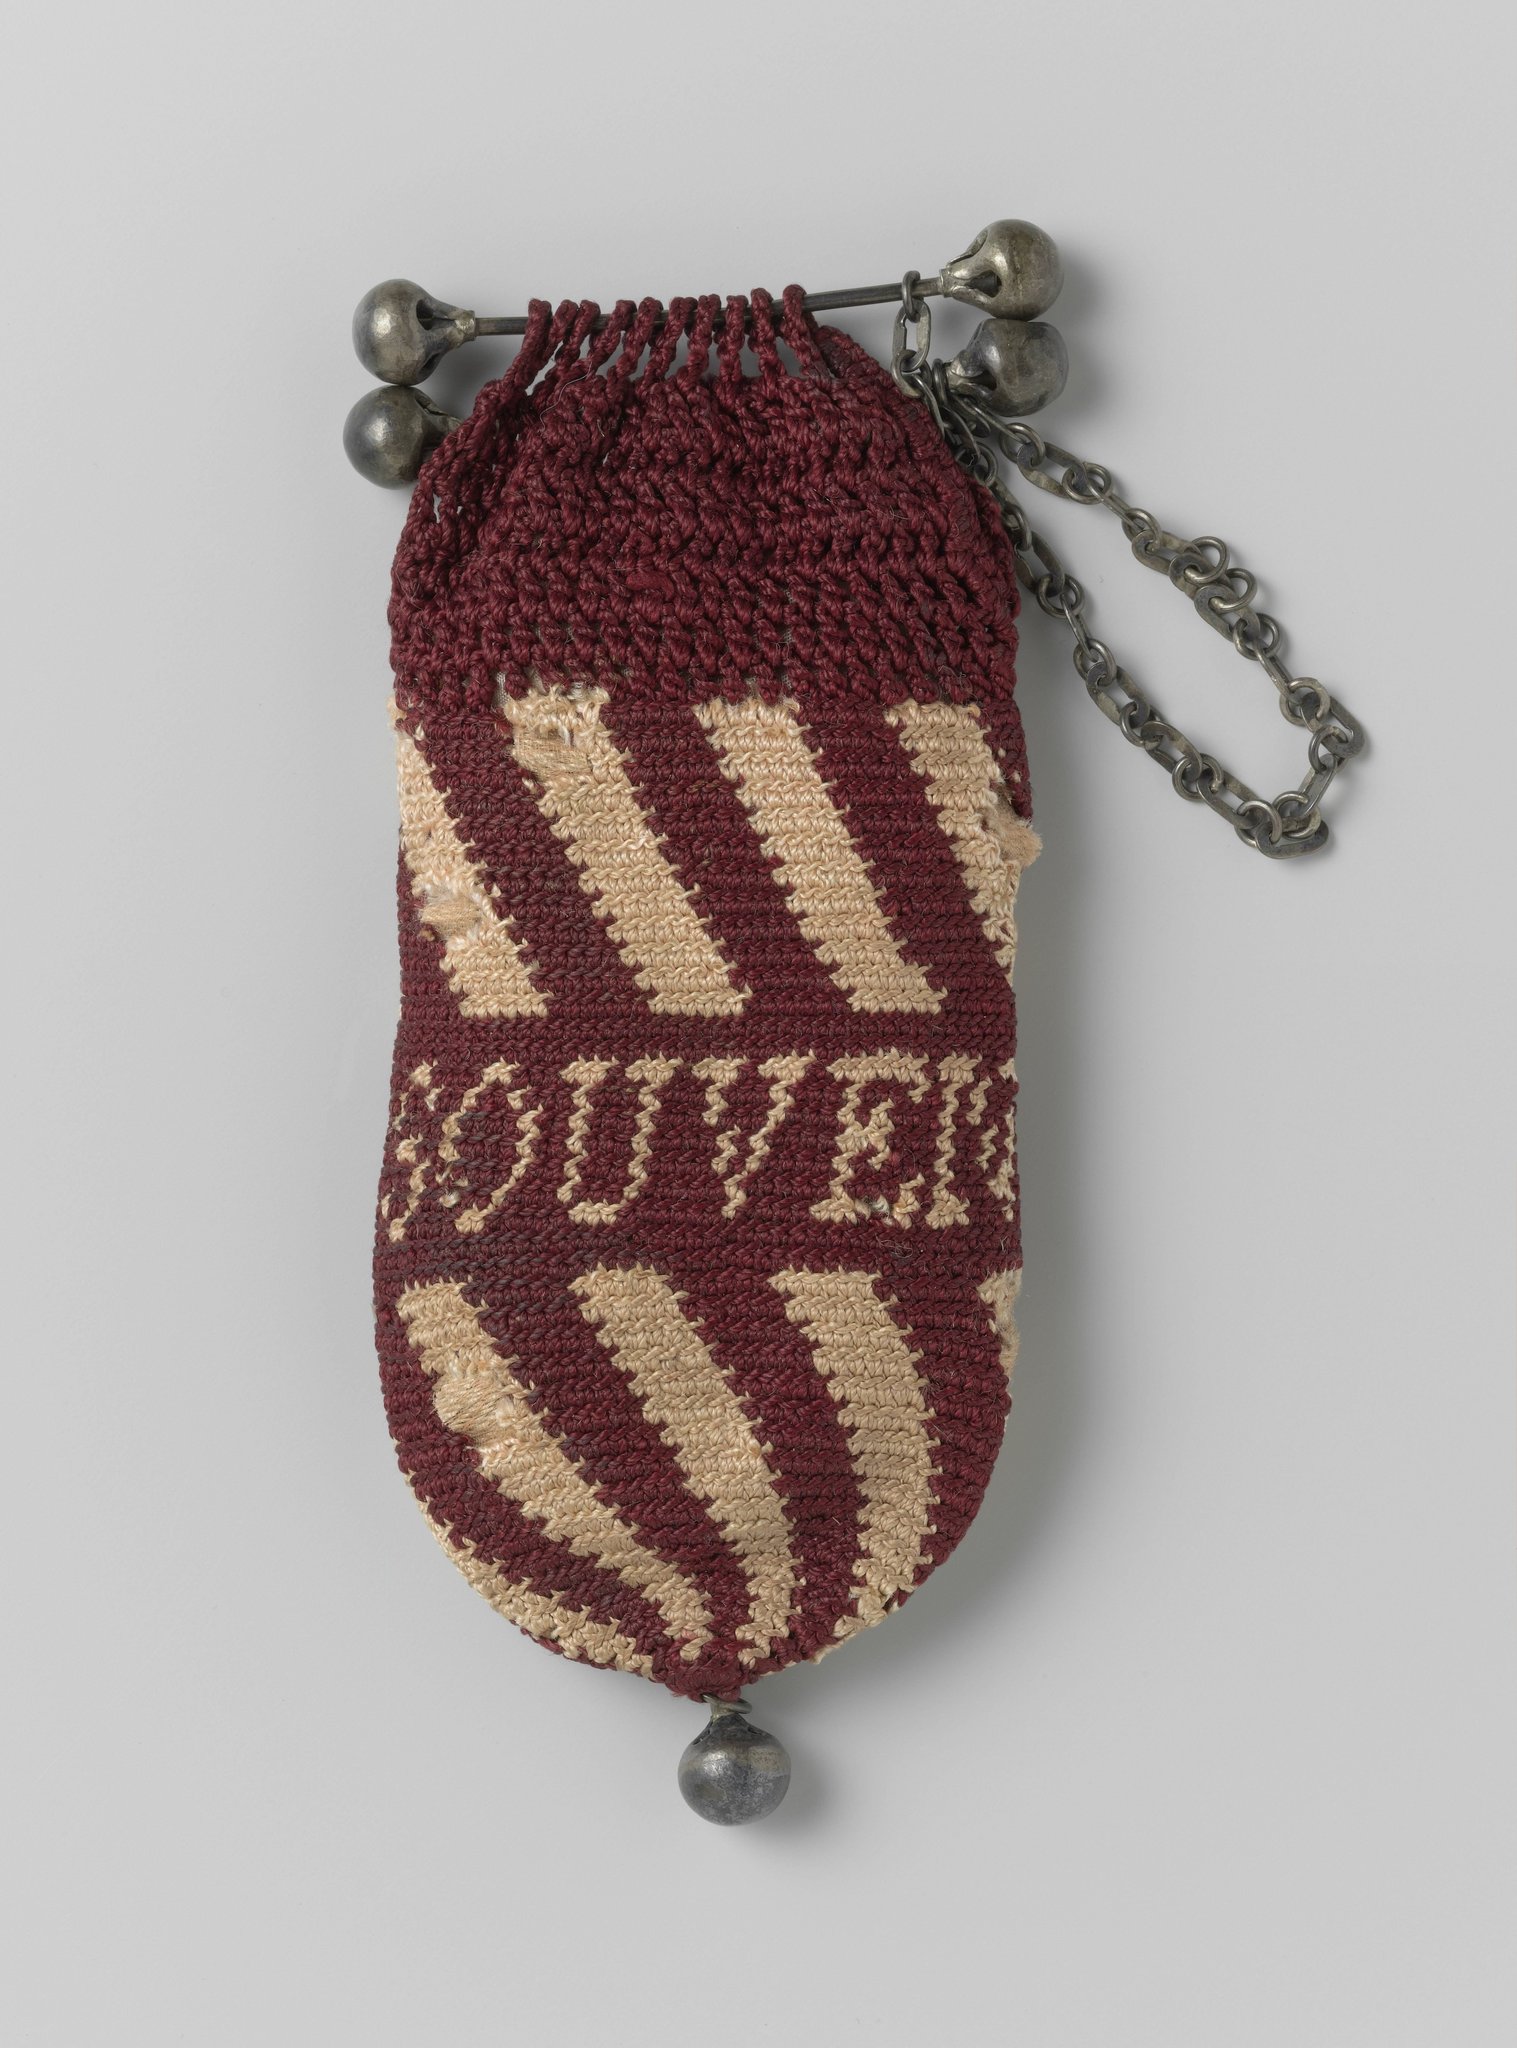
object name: beurs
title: Beurs van donkerrood en roze zijden haakwerk, waaraan twee metalen staven en een ketting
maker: Anonymous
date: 1820-1840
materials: metal, silk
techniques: crochet, forging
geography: switzerland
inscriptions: inscription: ‘SOUVENIR’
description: Langwerpige beurs van afwisselende donkerrode en roze banen van zijden haakwerk. Halverwege de beurs een donkerrode baan met in roze letters SOUVENIR. Aan de ronde onderkant hangt een kleine metalen bel. De beurs sluit door twee metalen staven die door gehaakte lussen zijn gestoken. Aan de vier uiteinden van de staven dezelfde kleine metalen bellen, en een metalen ketting. De beurs in ongevoerd.